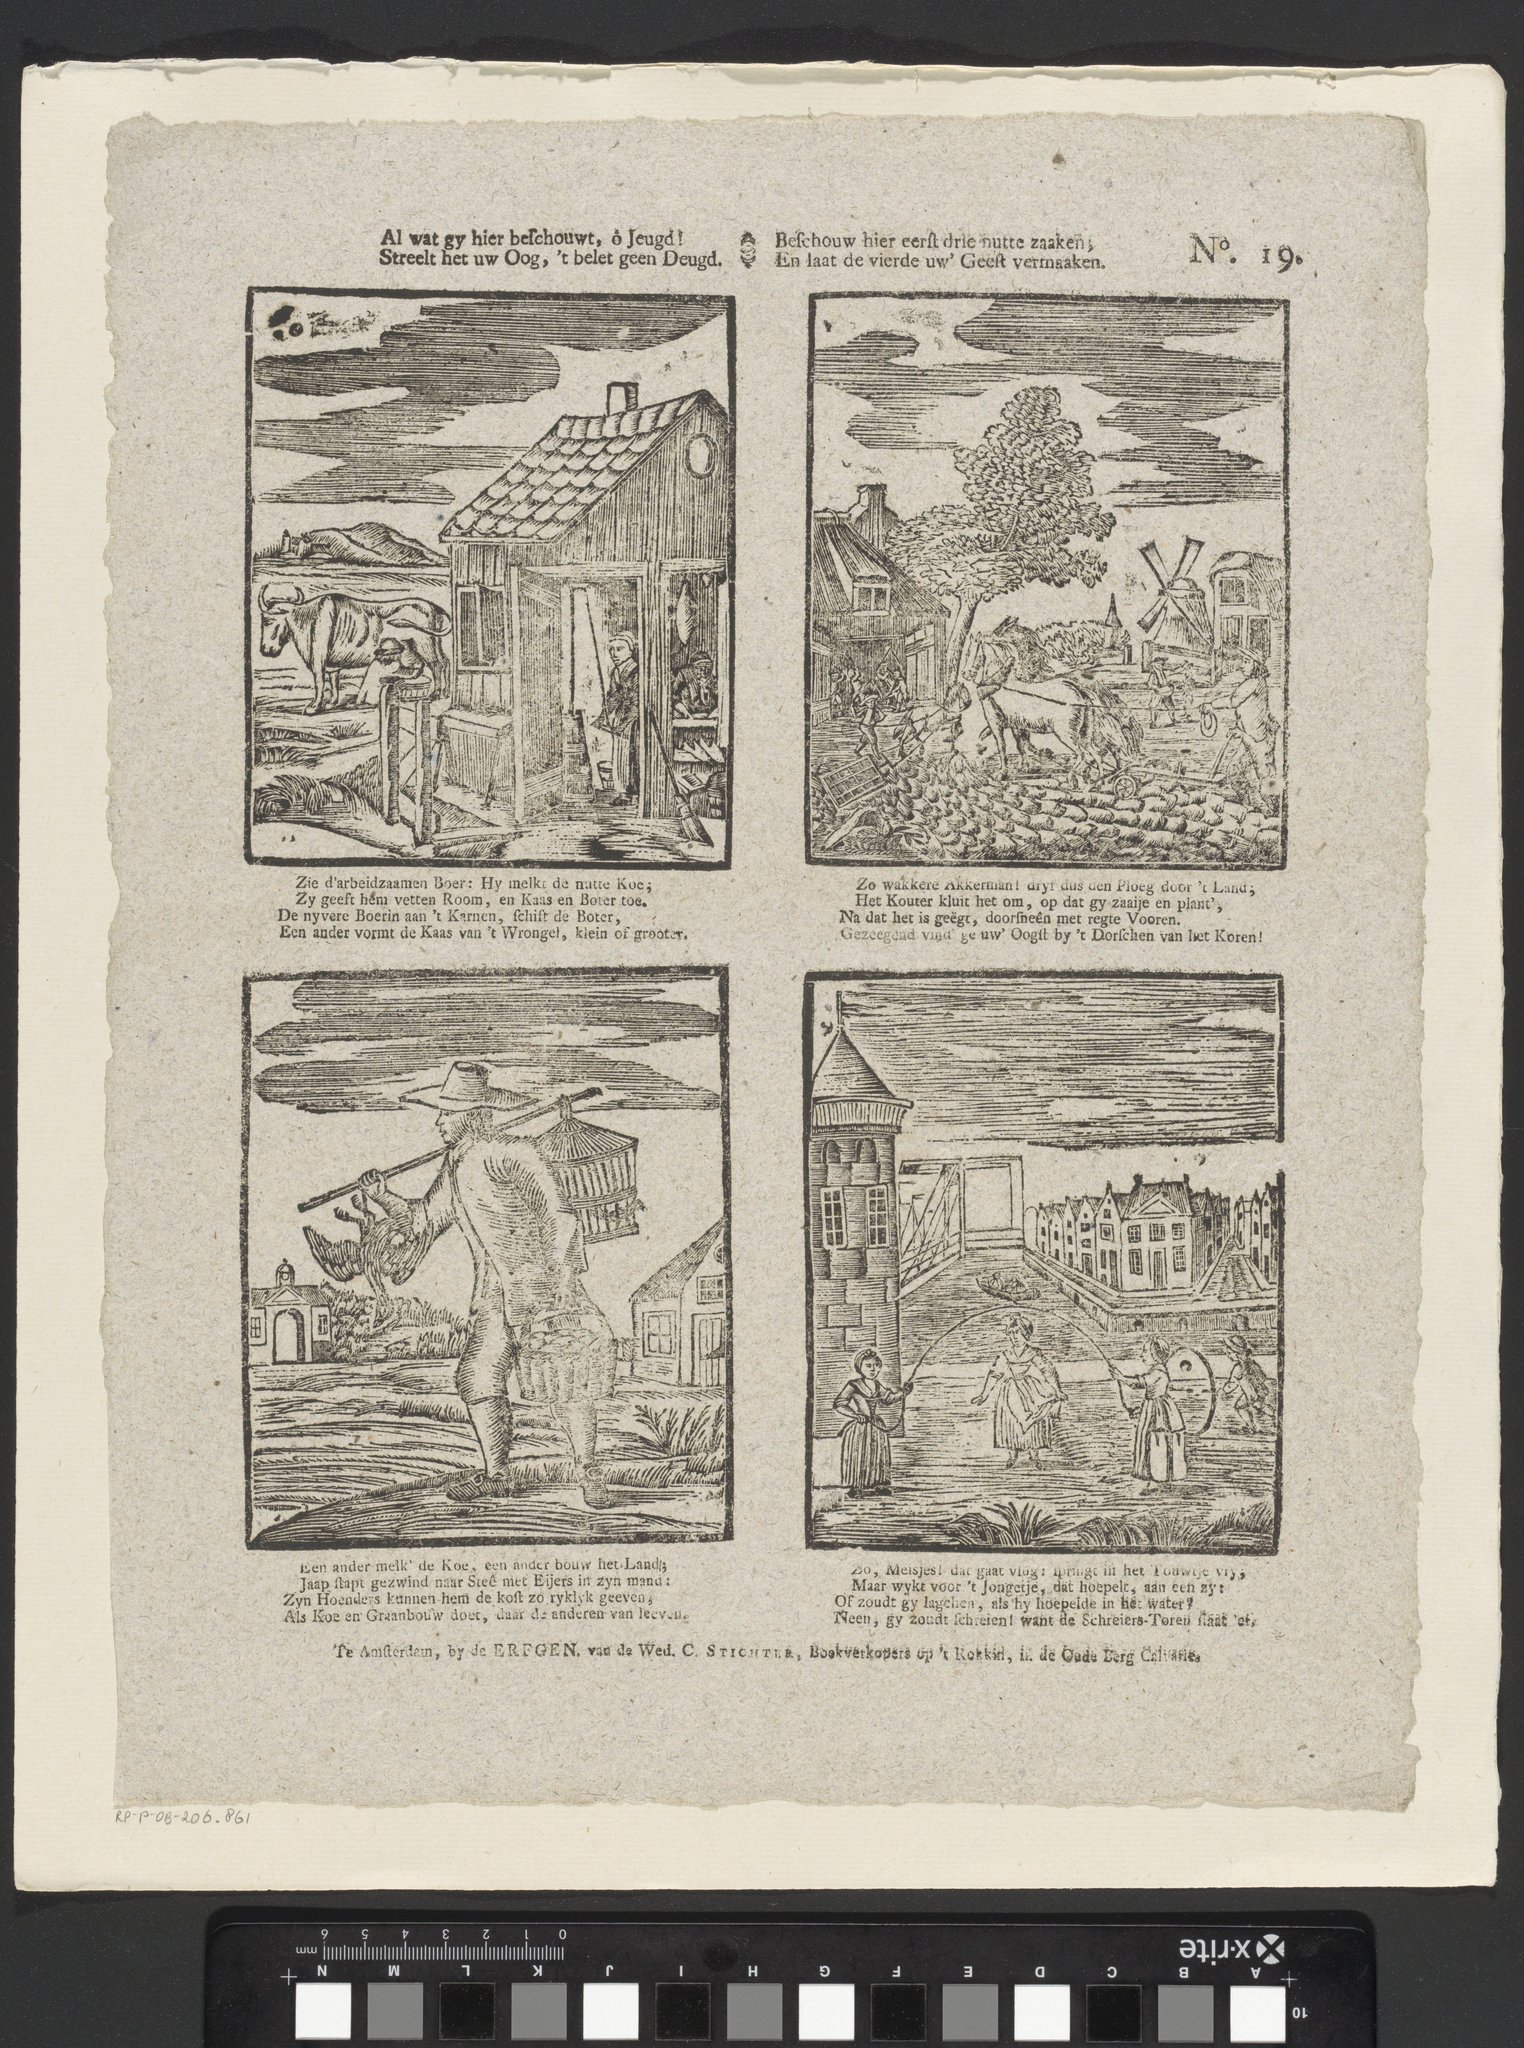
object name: print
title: Al wat gij hier beschouwt, ô jeugd! / Streelt het uw oog, 't belet geen deugd. / Beschouw hier eerst drie nutte zaaken; / En laat de vierde uw' geest vermaaken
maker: Anonymous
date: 1715-1813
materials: paper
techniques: letterpress printing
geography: amsterdam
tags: farmers, jumping-rope games, ploughing, farm (building), milking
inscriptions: collector's mark: Lugt 2760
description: Blad met 4 voorstellingen van de wekzaamheden van een boer en van kinderen die touwtjespringen. Onder elke afbeelding een vierregelig vers. Genummerd rechtsboven: No. 19.